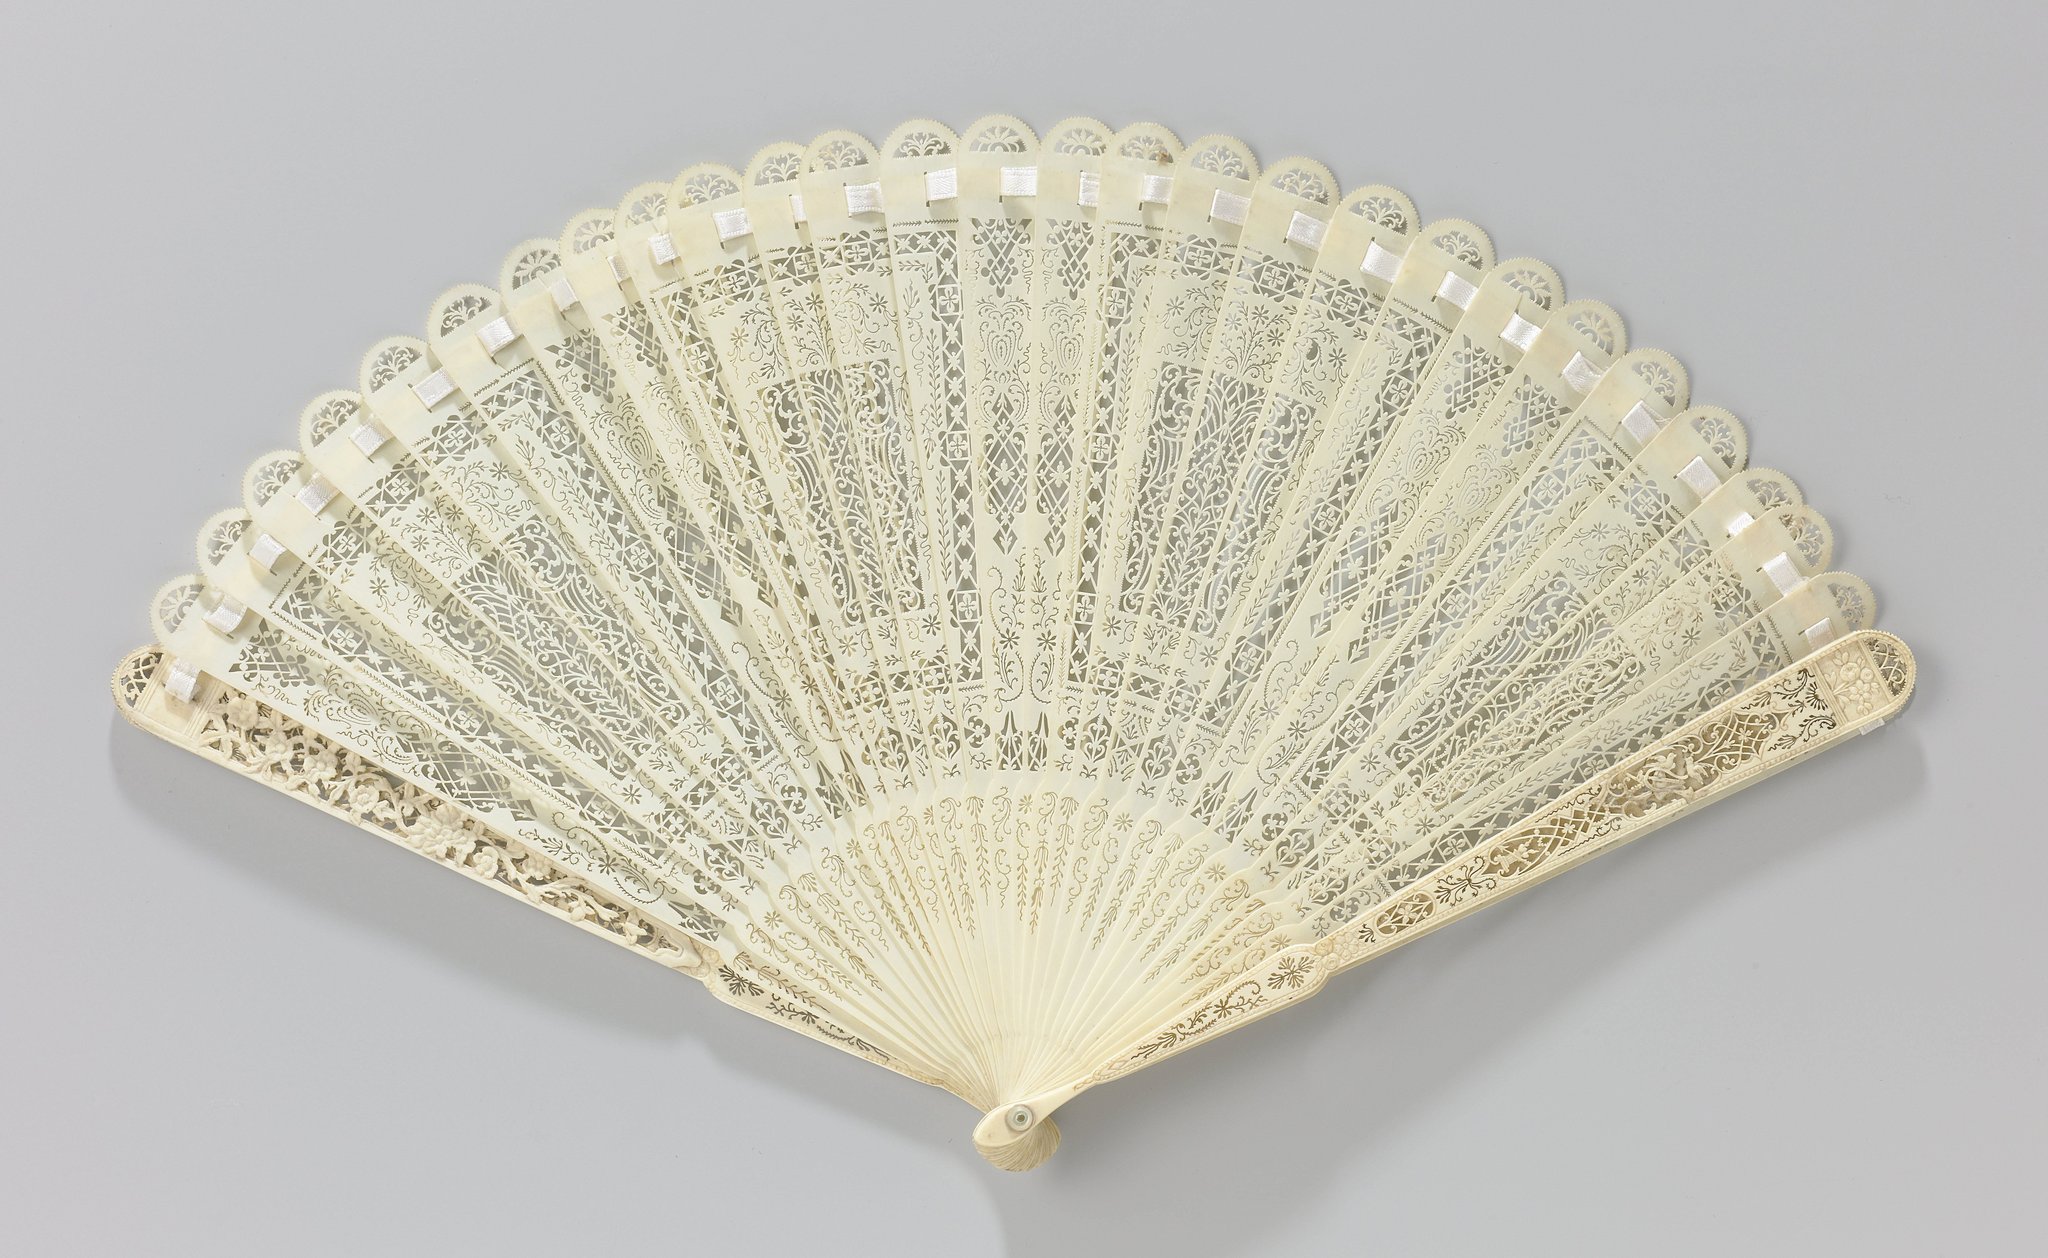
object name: brisé fan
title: Brisé-waaier van gesneden ivoor met symmetrisch opgebouwd patroon en op de sluitbenen een huwelijksaltaar onder twee vogels bij een trofee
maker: Anonymous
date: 1770-1780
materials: copper, ivory, mother of pearl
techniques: cutting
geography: guangdong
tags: johanna catharina adelaïde barones snouckaert van schauburg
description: Brisé-waaier van gesneden ivoor met symmetrisch opgebouwd patroon voorzien van vier rechthoeken gevuld met accanthusbladeren en servetwerk omlijst door gestapelde ornamenten met vierpassen, servetwerk en florale motieven, op de sluitbenen een huwelijksaltaar met twee brandende harten en pijl onder twee vogels bij een trofee met lier en doedelzak. Koperen sluitpin met parelmoeren rondje.